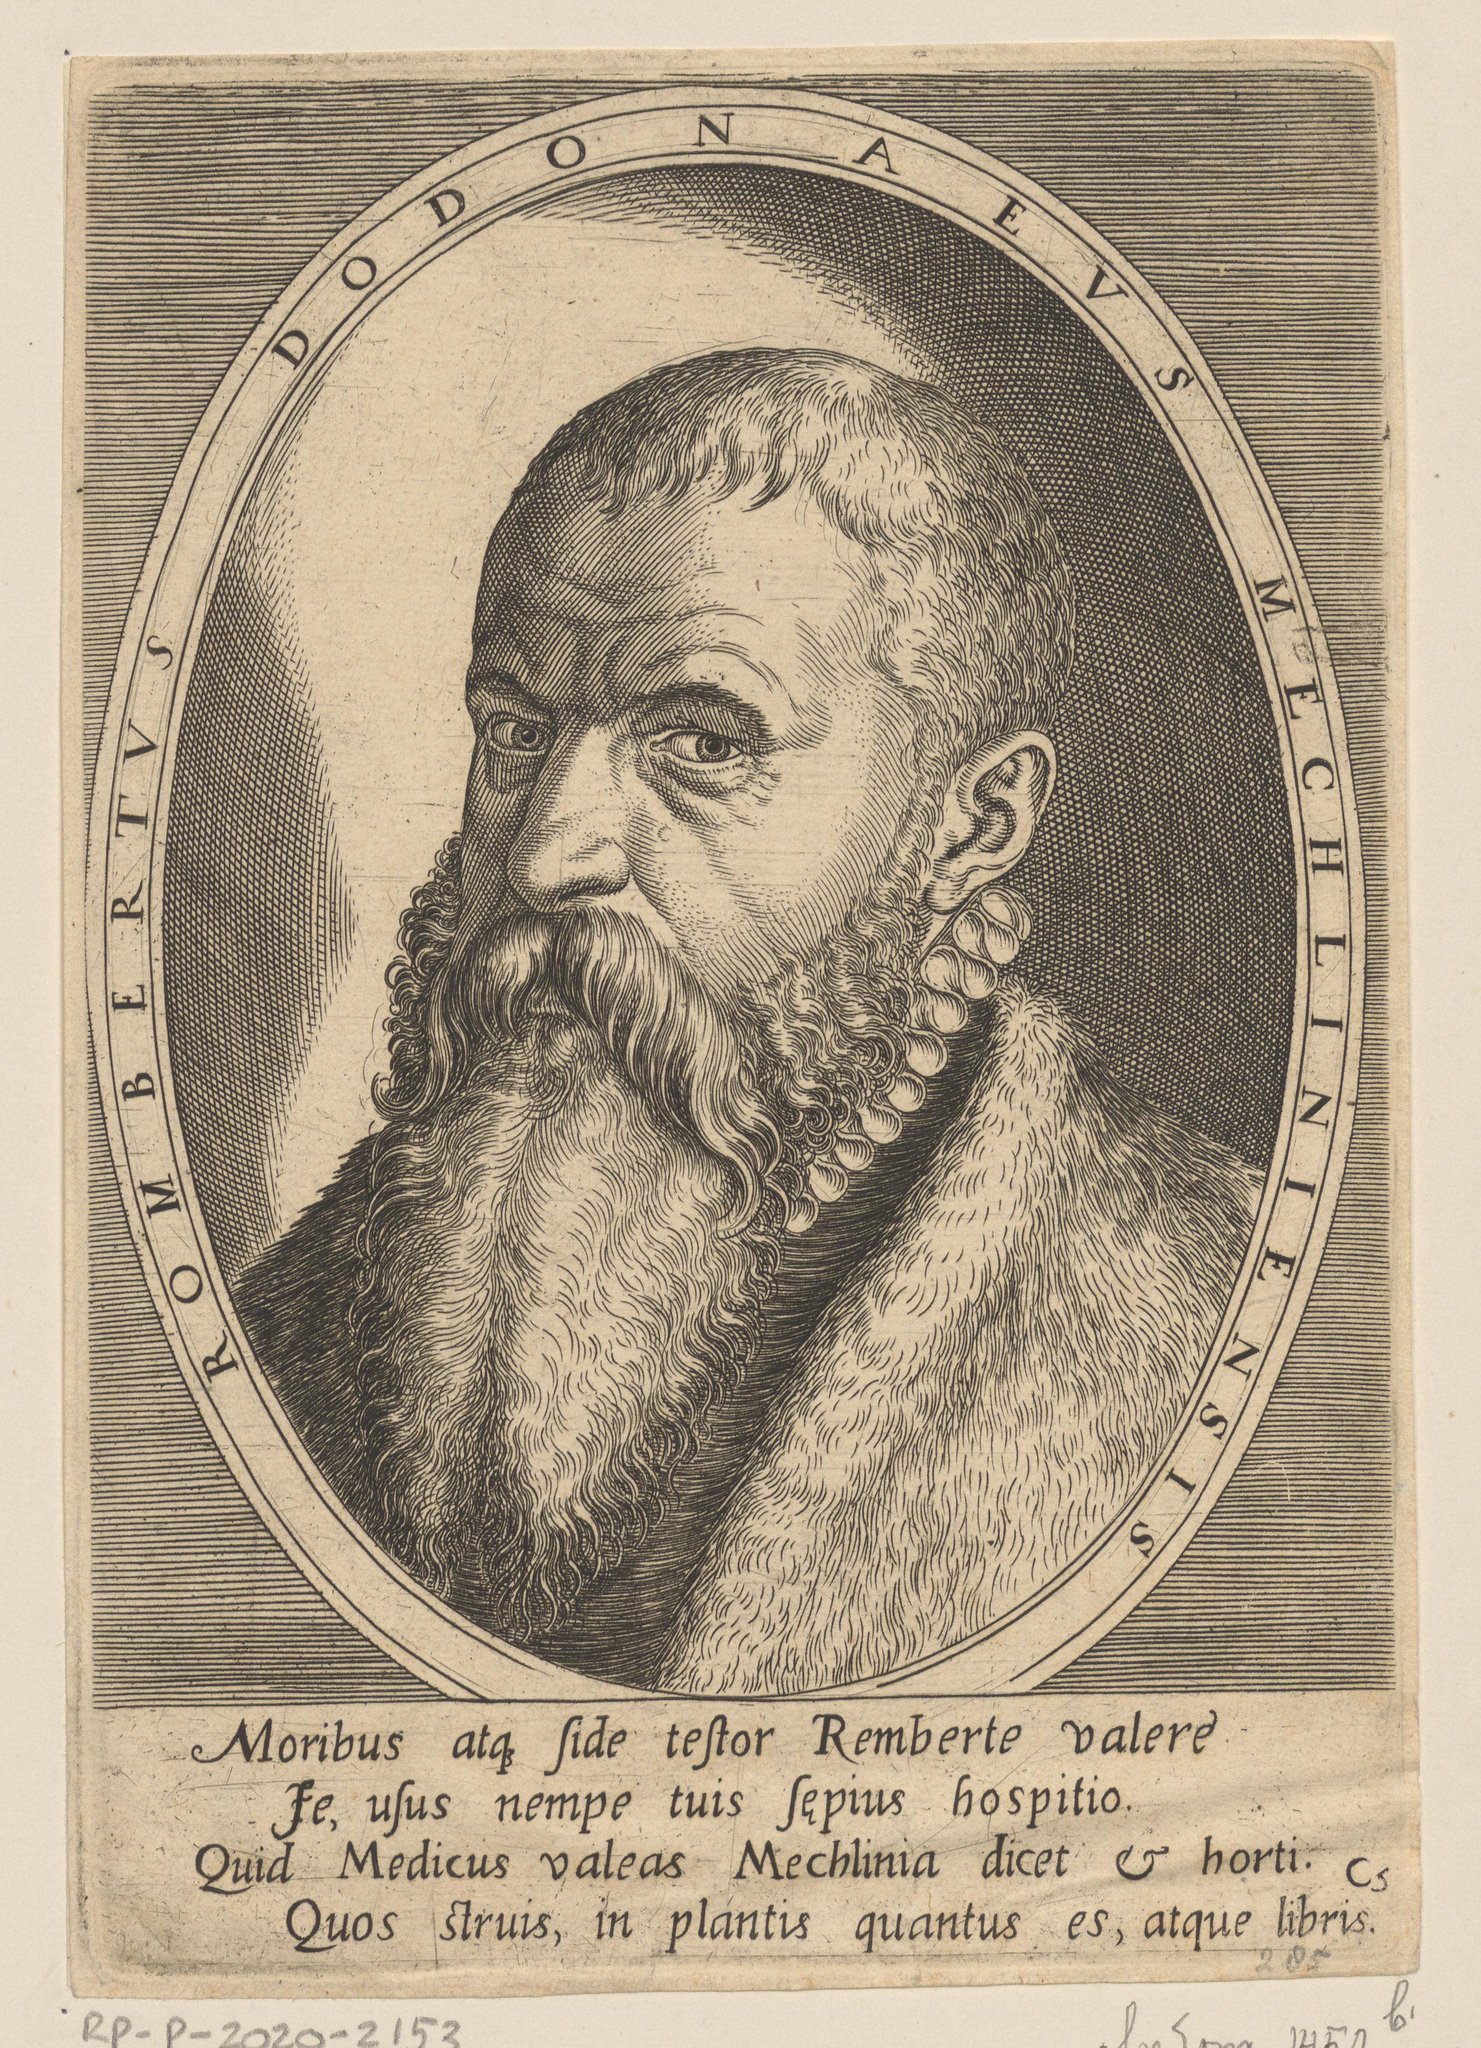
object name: print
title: Portret van Rembertus Dodonaeus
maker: philips galle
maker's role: print maker, publisher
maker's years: 1537-1612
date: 1572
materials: paper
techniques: engraving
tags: mechelen, leiden, rembertus dodonaeus, historical persons, physician, doctor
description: Eerdere staat van prent gebruikt in: Virorum doctorum de disciplinis benemerentium effigies XLIIII. Antwerpen: Philips Galle, 1572.